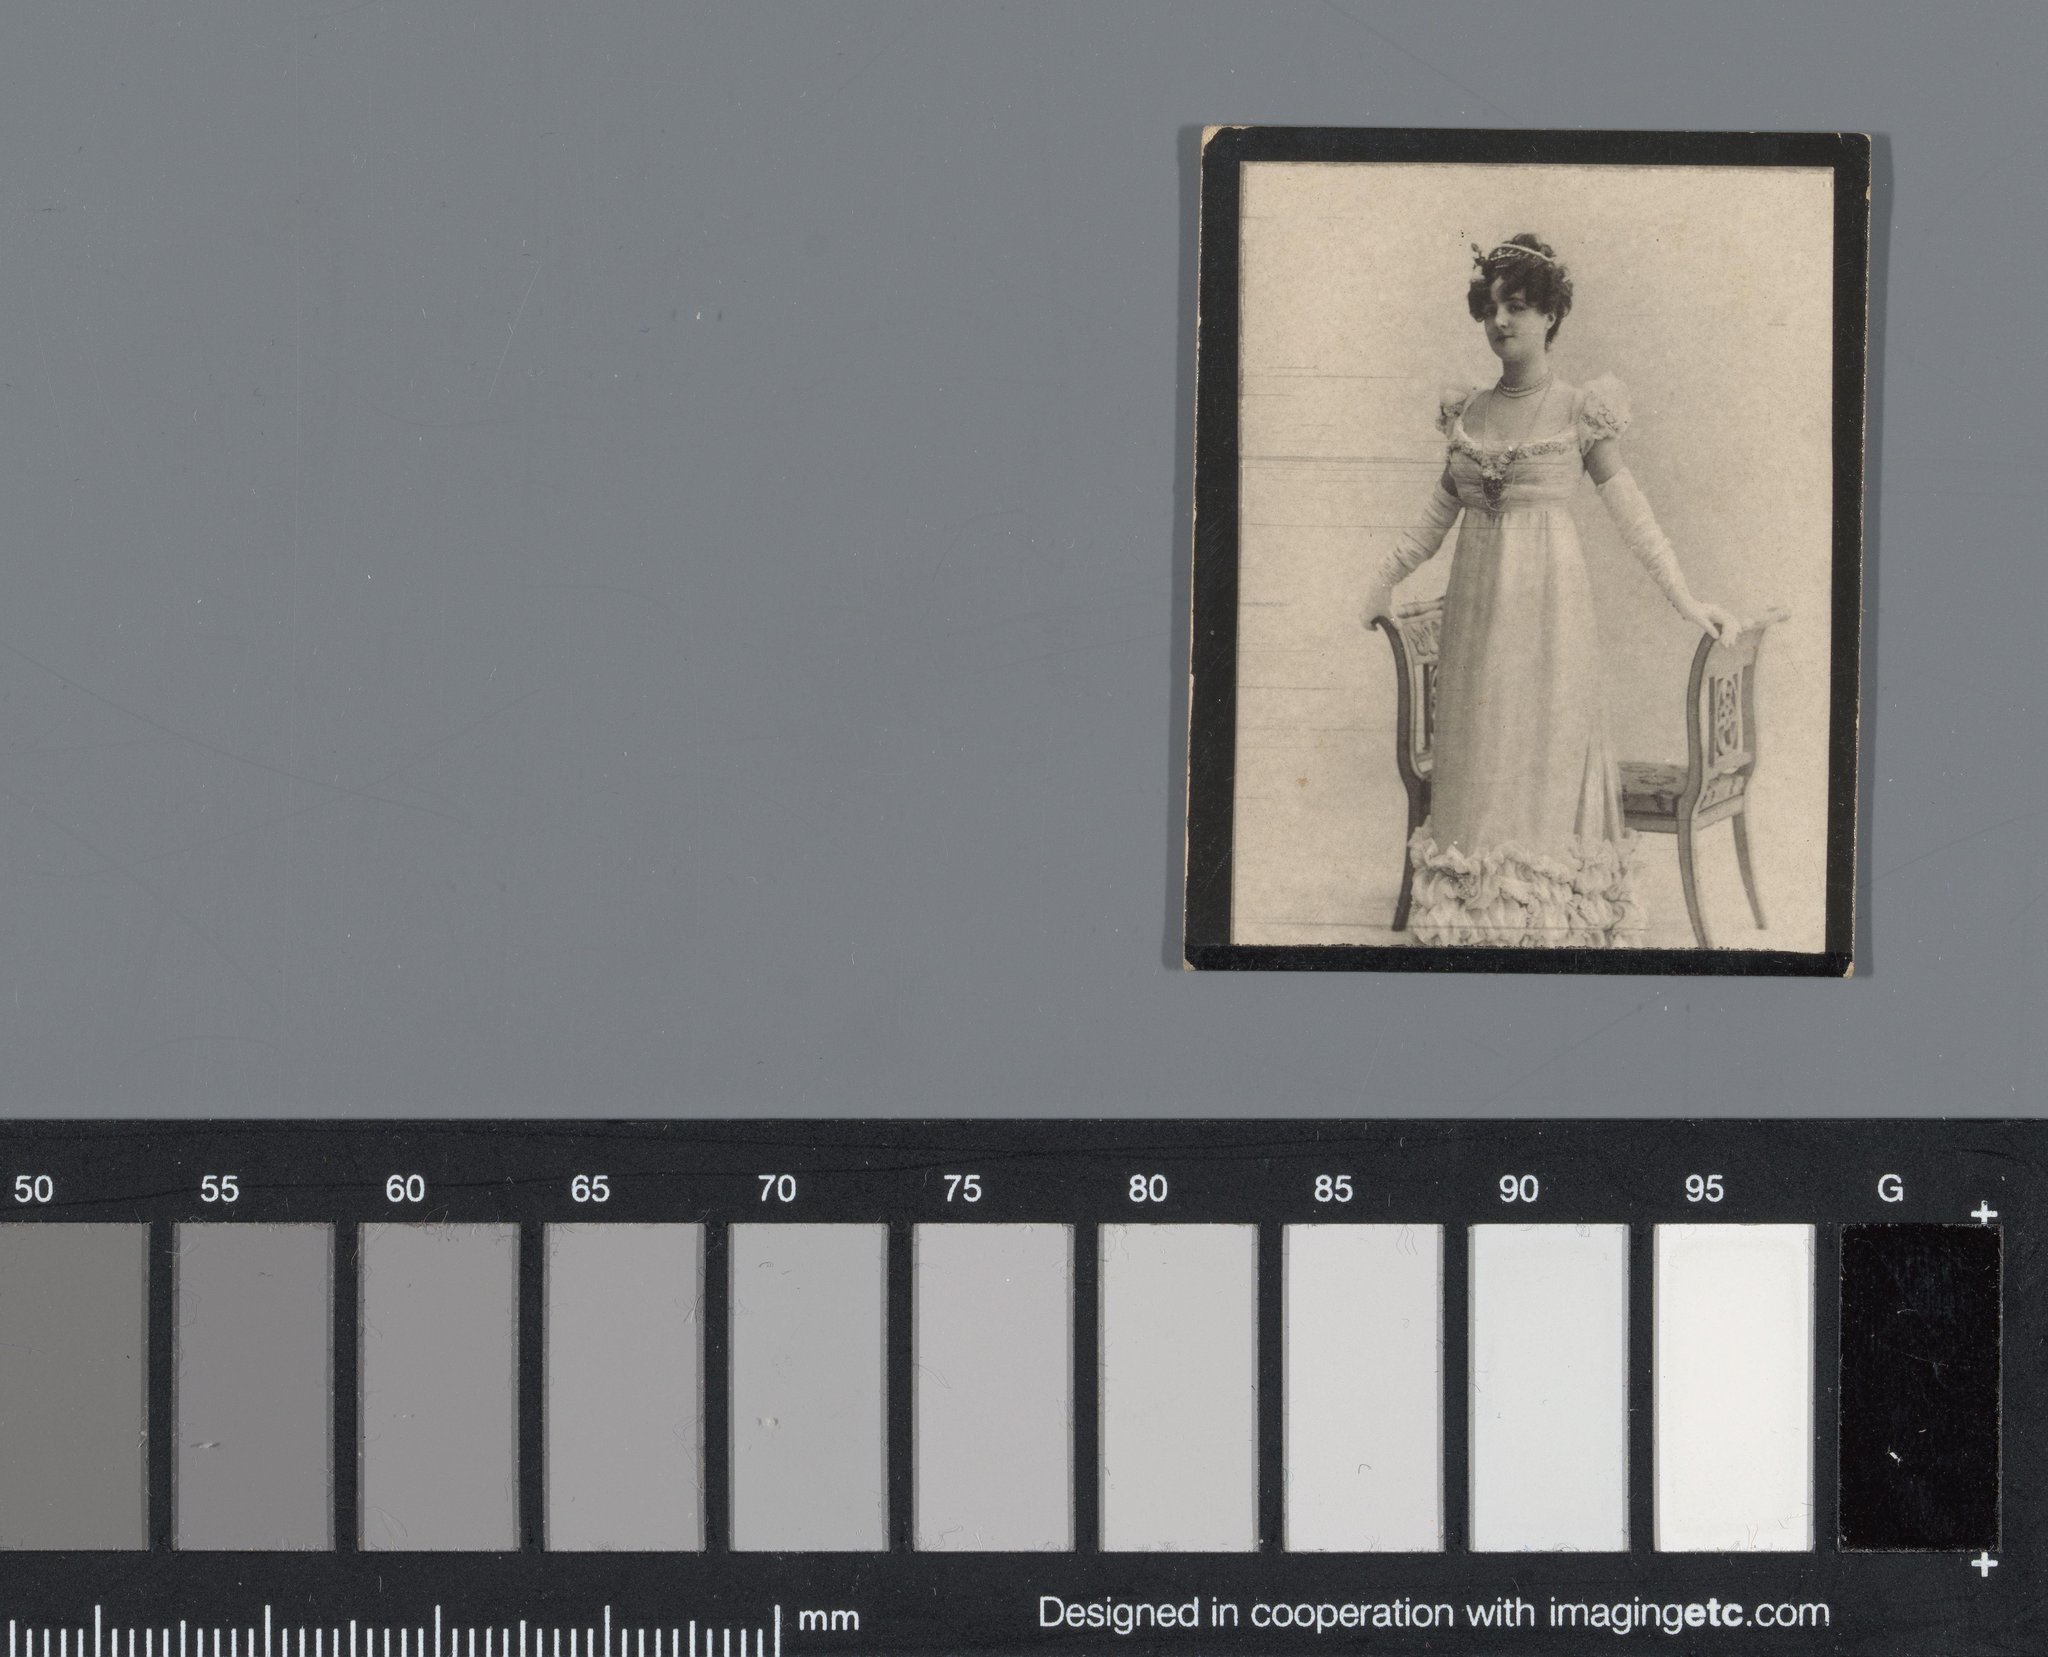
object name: photograph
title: Portret van een onbekende vrouw in avondkleding, reclame voor A. Claeys & Vanden Bussche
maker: Anonymous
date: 1895-1910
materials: photographic support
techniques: gelatin silver print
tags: historical persons - bb - woman, dress, gown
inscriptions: inscription: ‘Manufactory/ of/ Cigars and Cigarillos/ A. CLAEYS/ & VANDEN BUSSCHE/ A C. B./ TRADE MARK./ made in/ ANTWERP and RETHY/ Especially for/ EXPORTATION.’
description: Dergelijke foto's stonden bekend als 'zwartjes'. Men verkreeg ze bij aanschaf van bepaalde merken thee, cacao, sigaretten, beschuit, etc. om te verzamelen. Er waren speciaal voor de 'zwartjes' verzamelalbums in omloop.